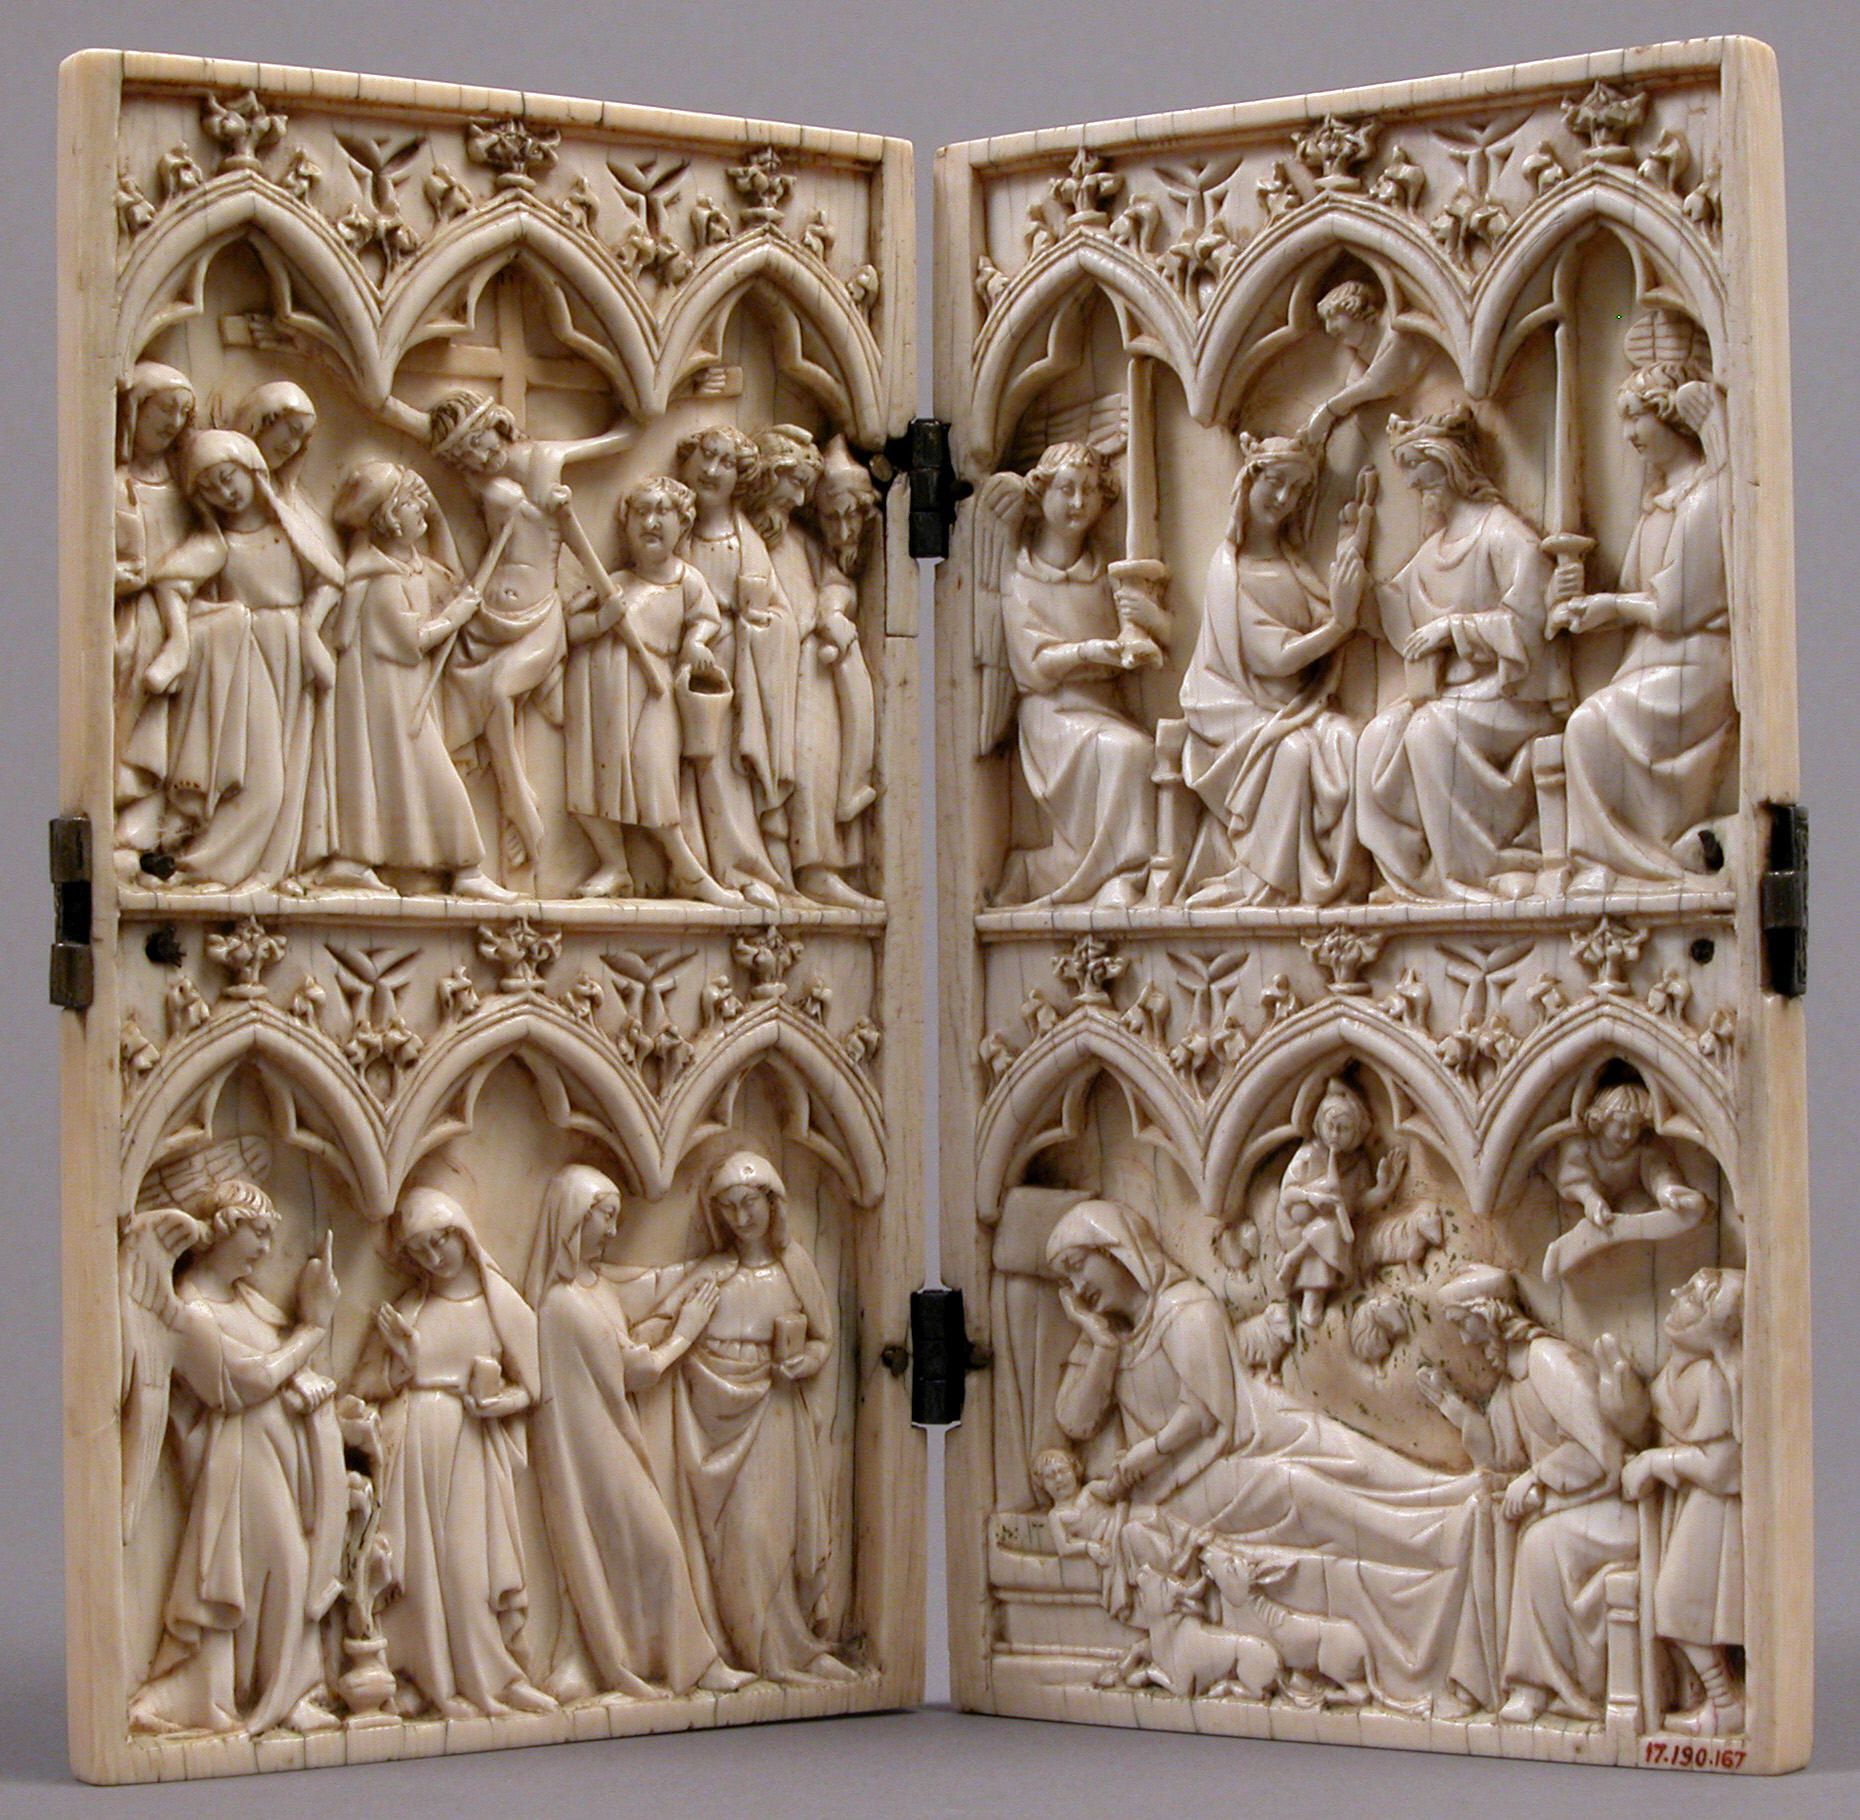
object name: diptych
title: Diptych with Annunciation, Visitation, Nativity, Crucifixion, and Coronation of the Virgin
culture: french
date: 1301-1400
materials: ivory, metal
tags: angels,virgin mary,annunciation,crucifixion,nativity,visitation